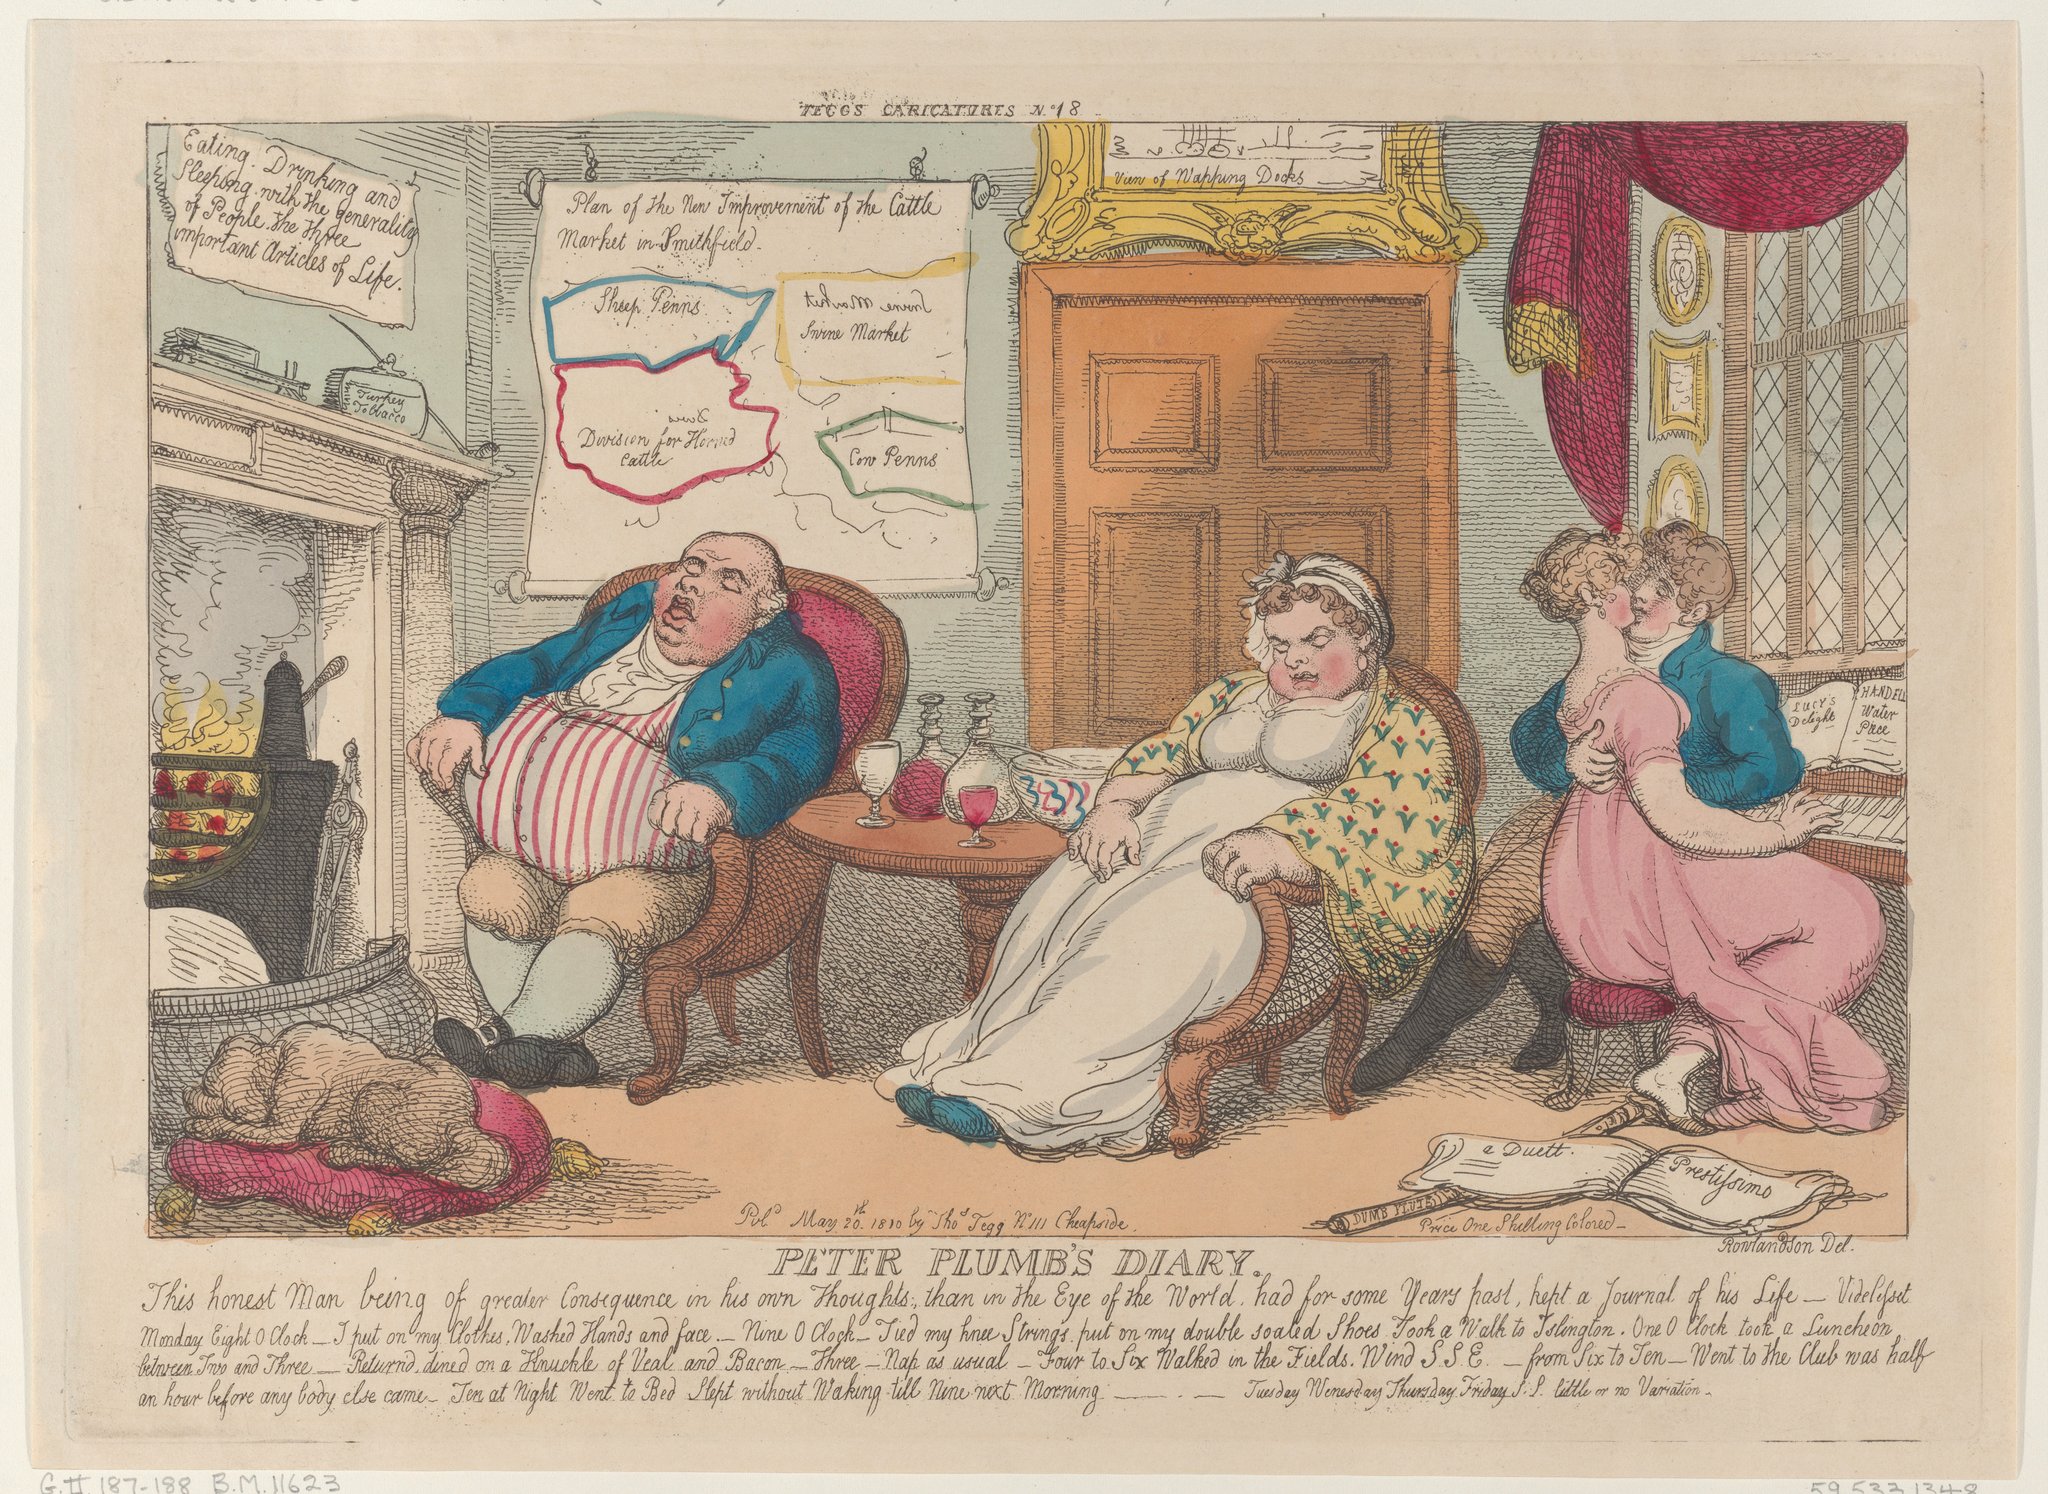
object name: print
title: Peter Plumb's Diary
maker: thomas rowlandson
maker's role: artist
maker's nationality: british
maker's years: 1757-1827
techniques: etching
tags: satire,sleeping,couples,men,women,dogs